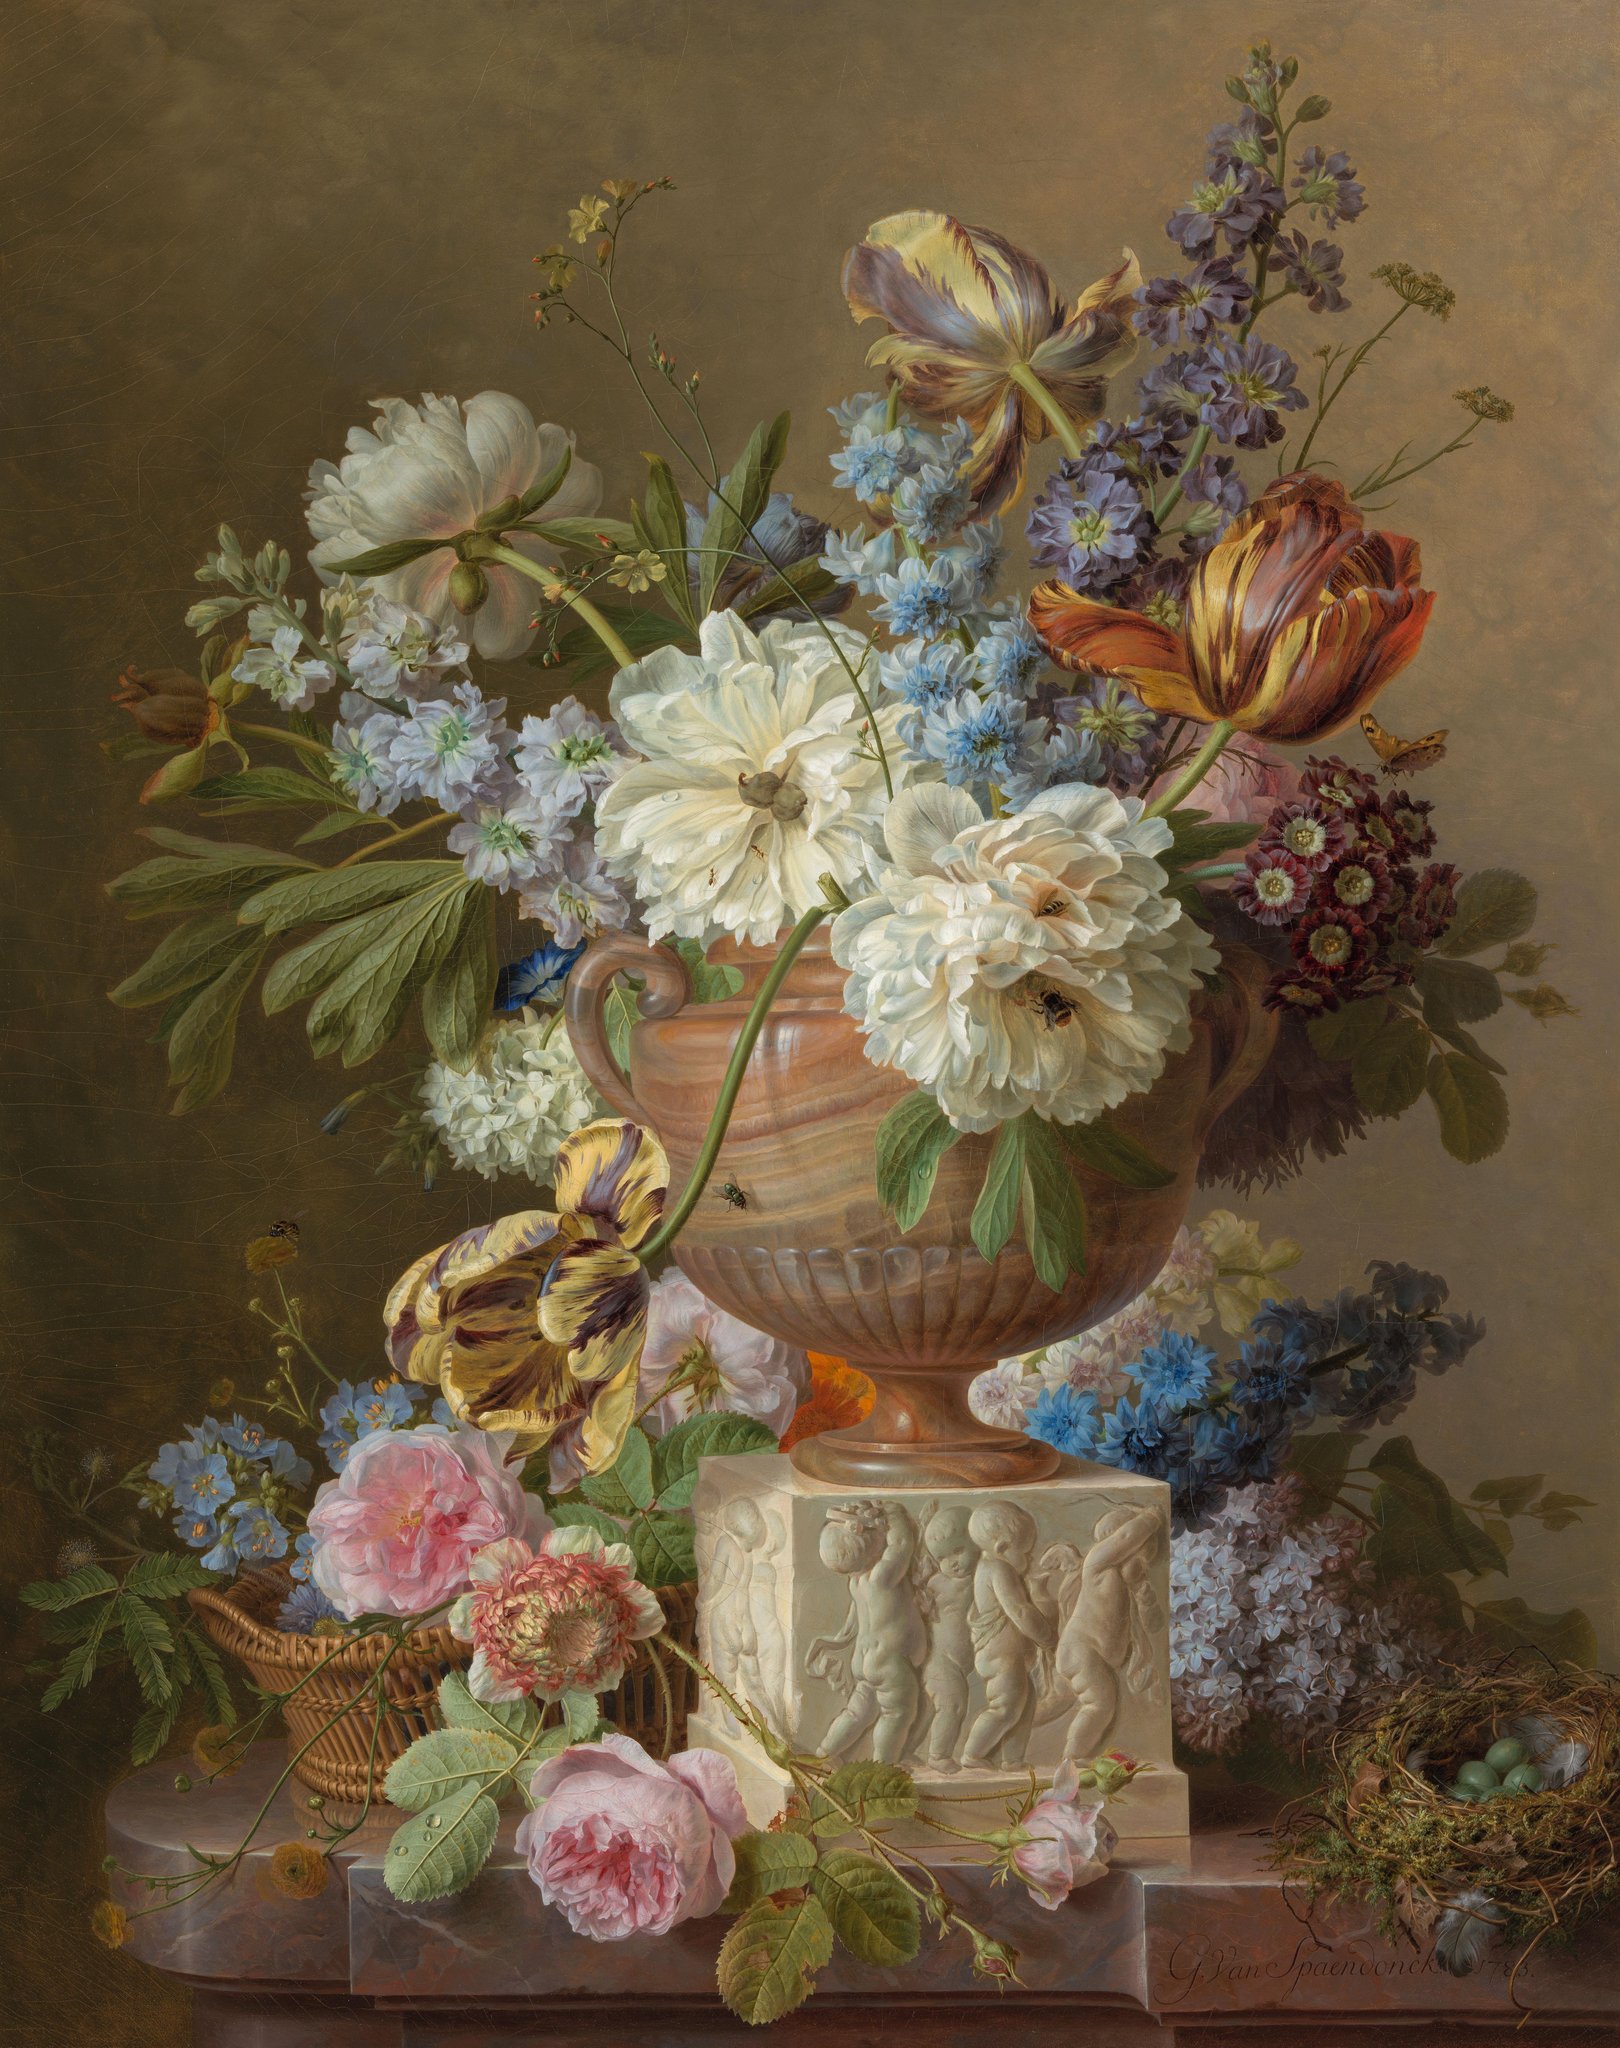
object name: painting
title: Flower Still-life with an Alabaster Vase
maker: gerard van spaendonck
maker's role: draughtsman, print maker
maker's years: 1746-1822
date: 1783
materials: canvas, oil, paint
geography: paris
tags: flowers, cut flowers; nosegay, bunch of flowers, birds (+ egg), piece of sculpture, reproduction of a piece of sculpture, flowers in a vase, insects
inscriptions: signature and date: ‘G. Van Spaendonck. 1783.’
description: Gerard van Spaendonck from Tilburg made his career in Paris, where he rose to become the botanical painter of the king of France, a highly distinguished position. His flower still lifes were considered as the best in his time. Exhibited at the Paris Salon in 1783, this painting was praised for the true-to-life flowers, insects, and objects. The window of the artist’s studio is reflected in the alabaster vase.